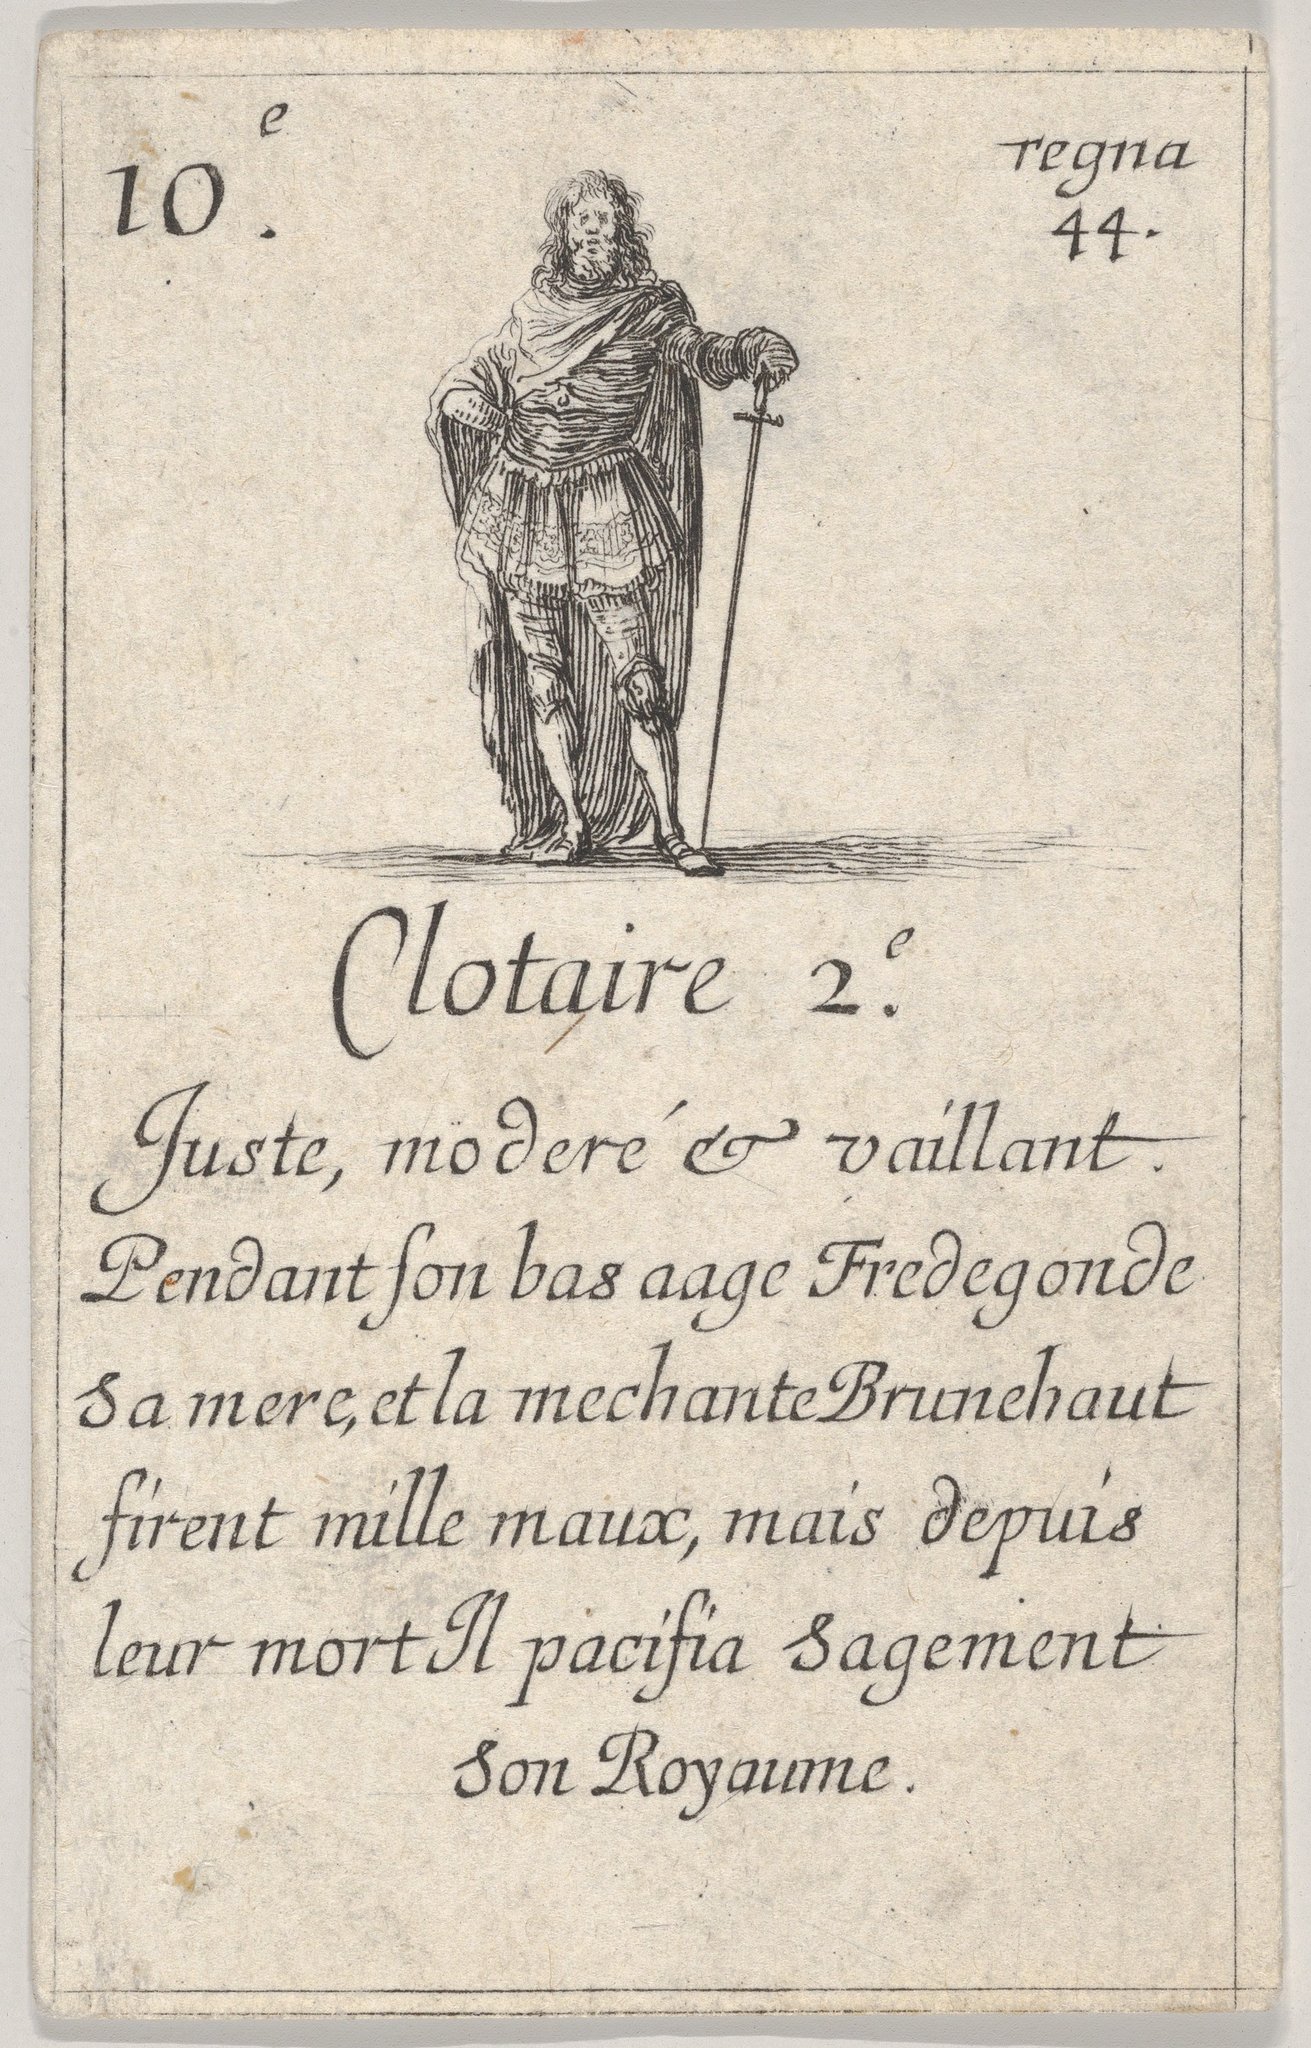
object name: print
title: Clotaire 2.-e / Juste, moderé..., from "Game of the Kings of France" (Jeu des Rois de France)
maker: stefano della bella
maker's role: artist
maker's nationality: italian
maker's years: 1610-1664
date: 1644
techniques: etching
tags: swords,kings